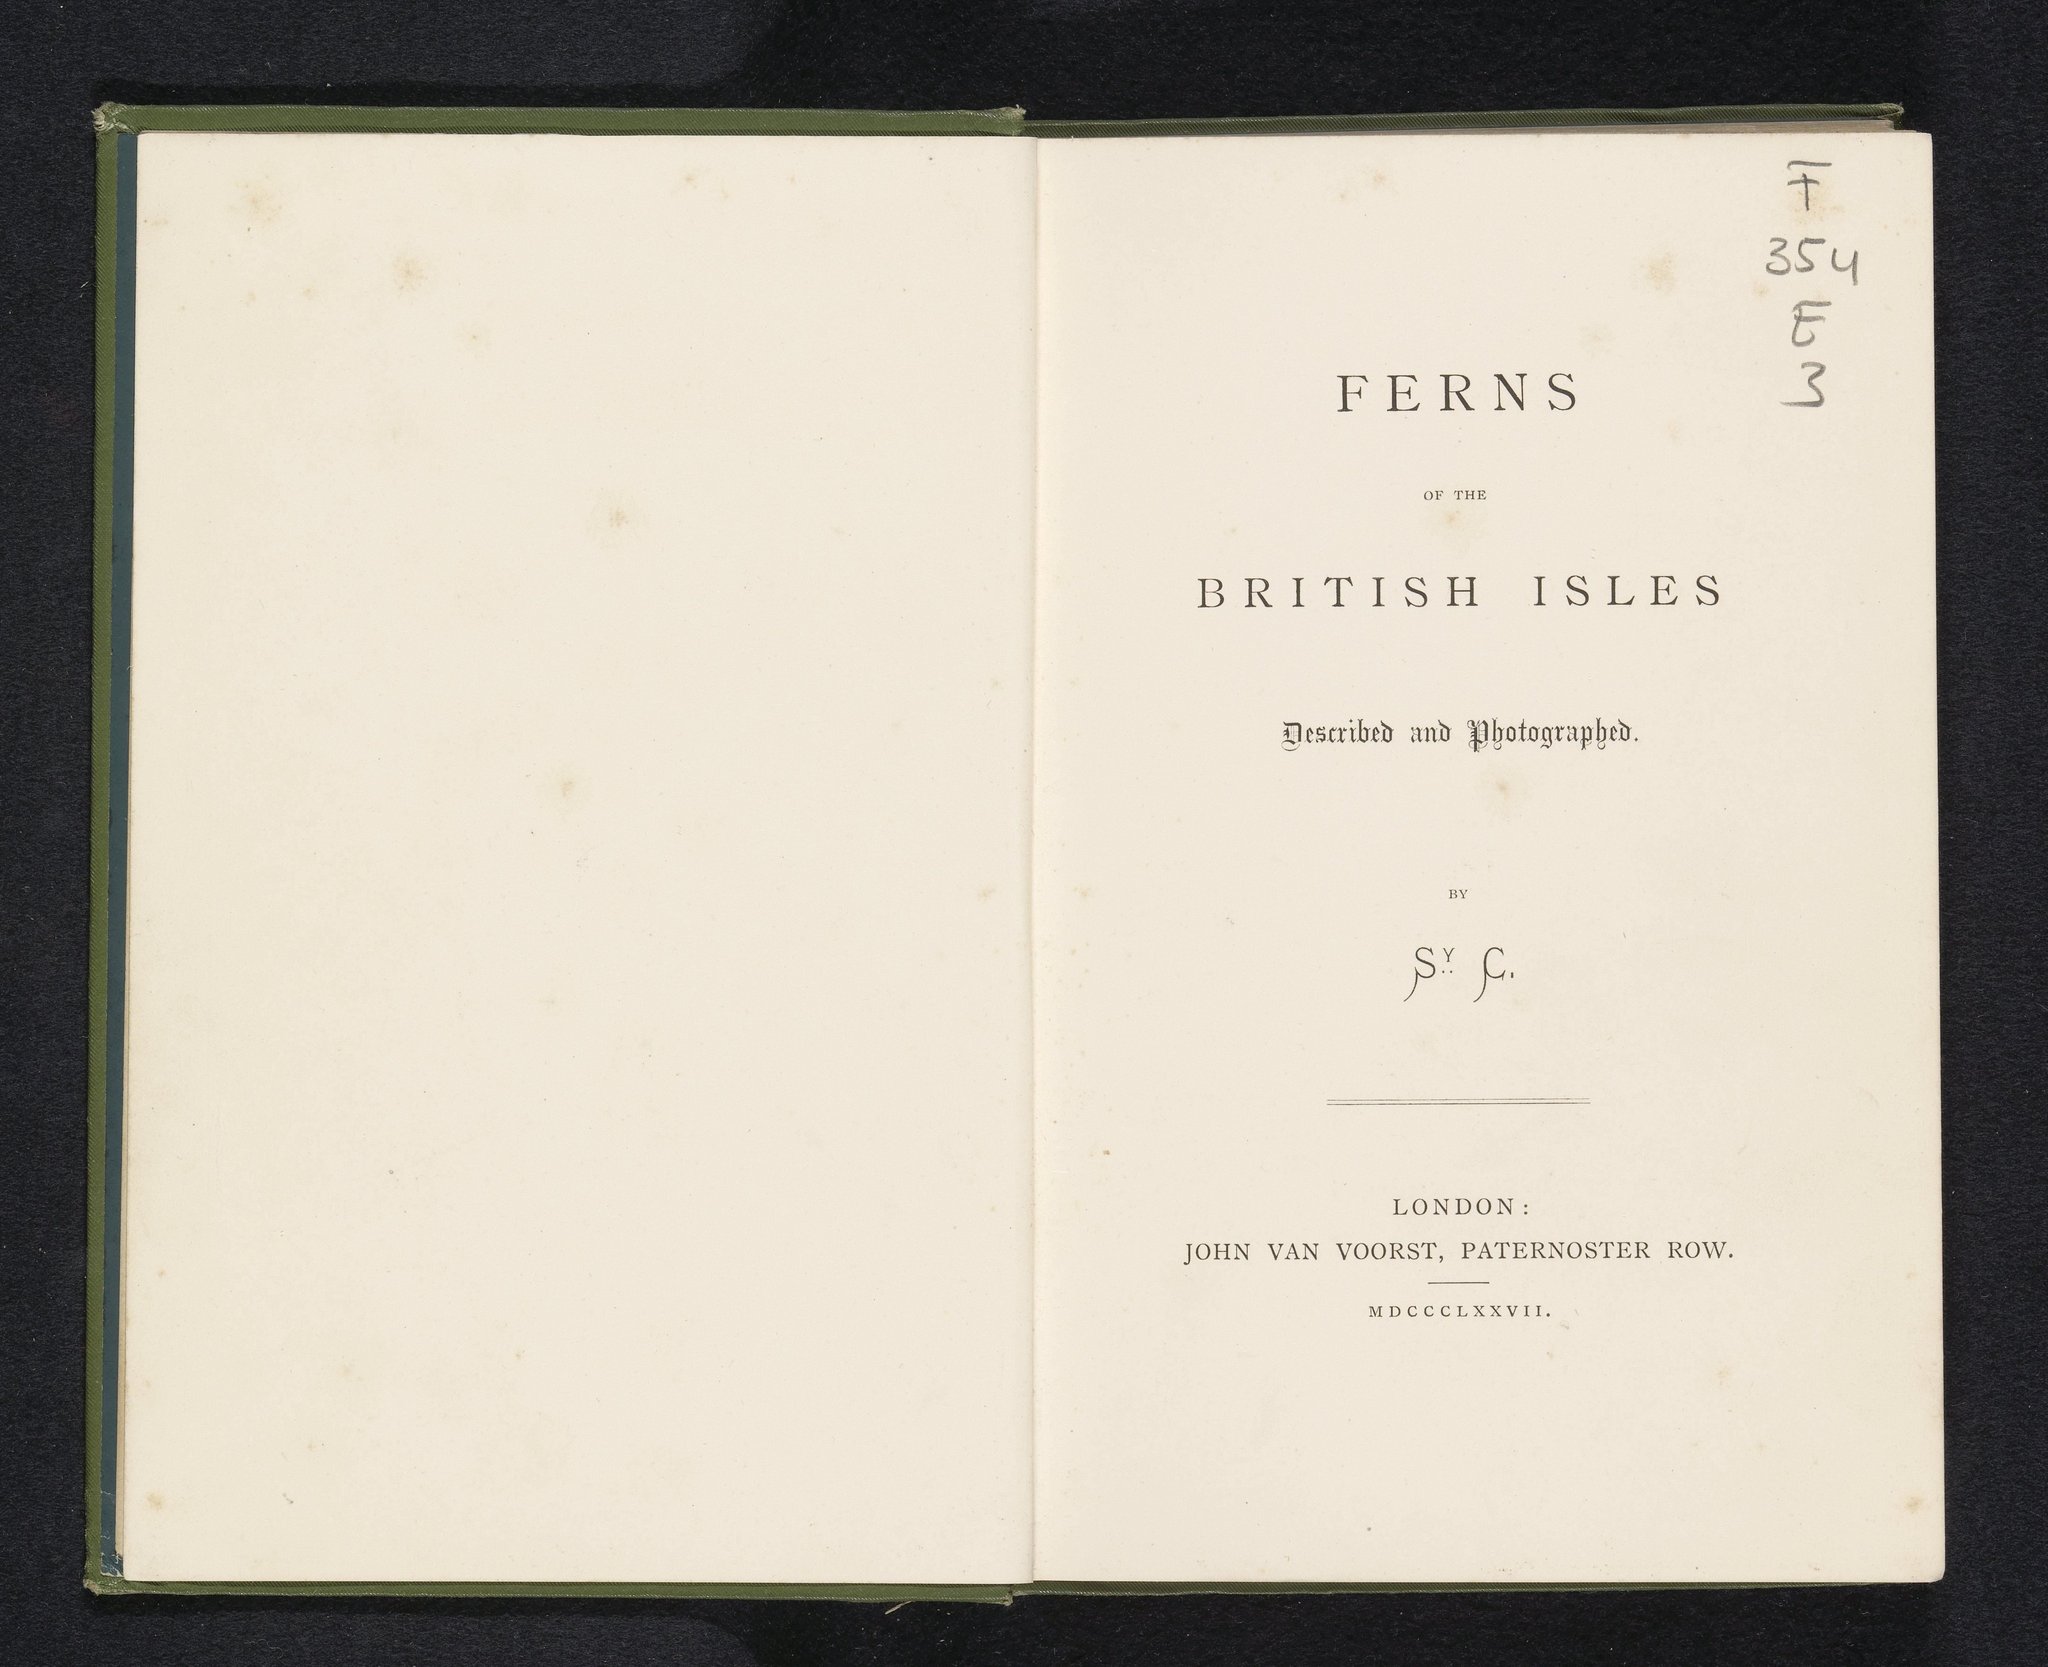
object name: book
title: Ferns of the British isles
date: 1877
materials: linen, paper, photographic support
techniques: albumen print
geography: london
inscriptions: inscription: ‘Miss Keurick with E.R.'s love Dear 1877’